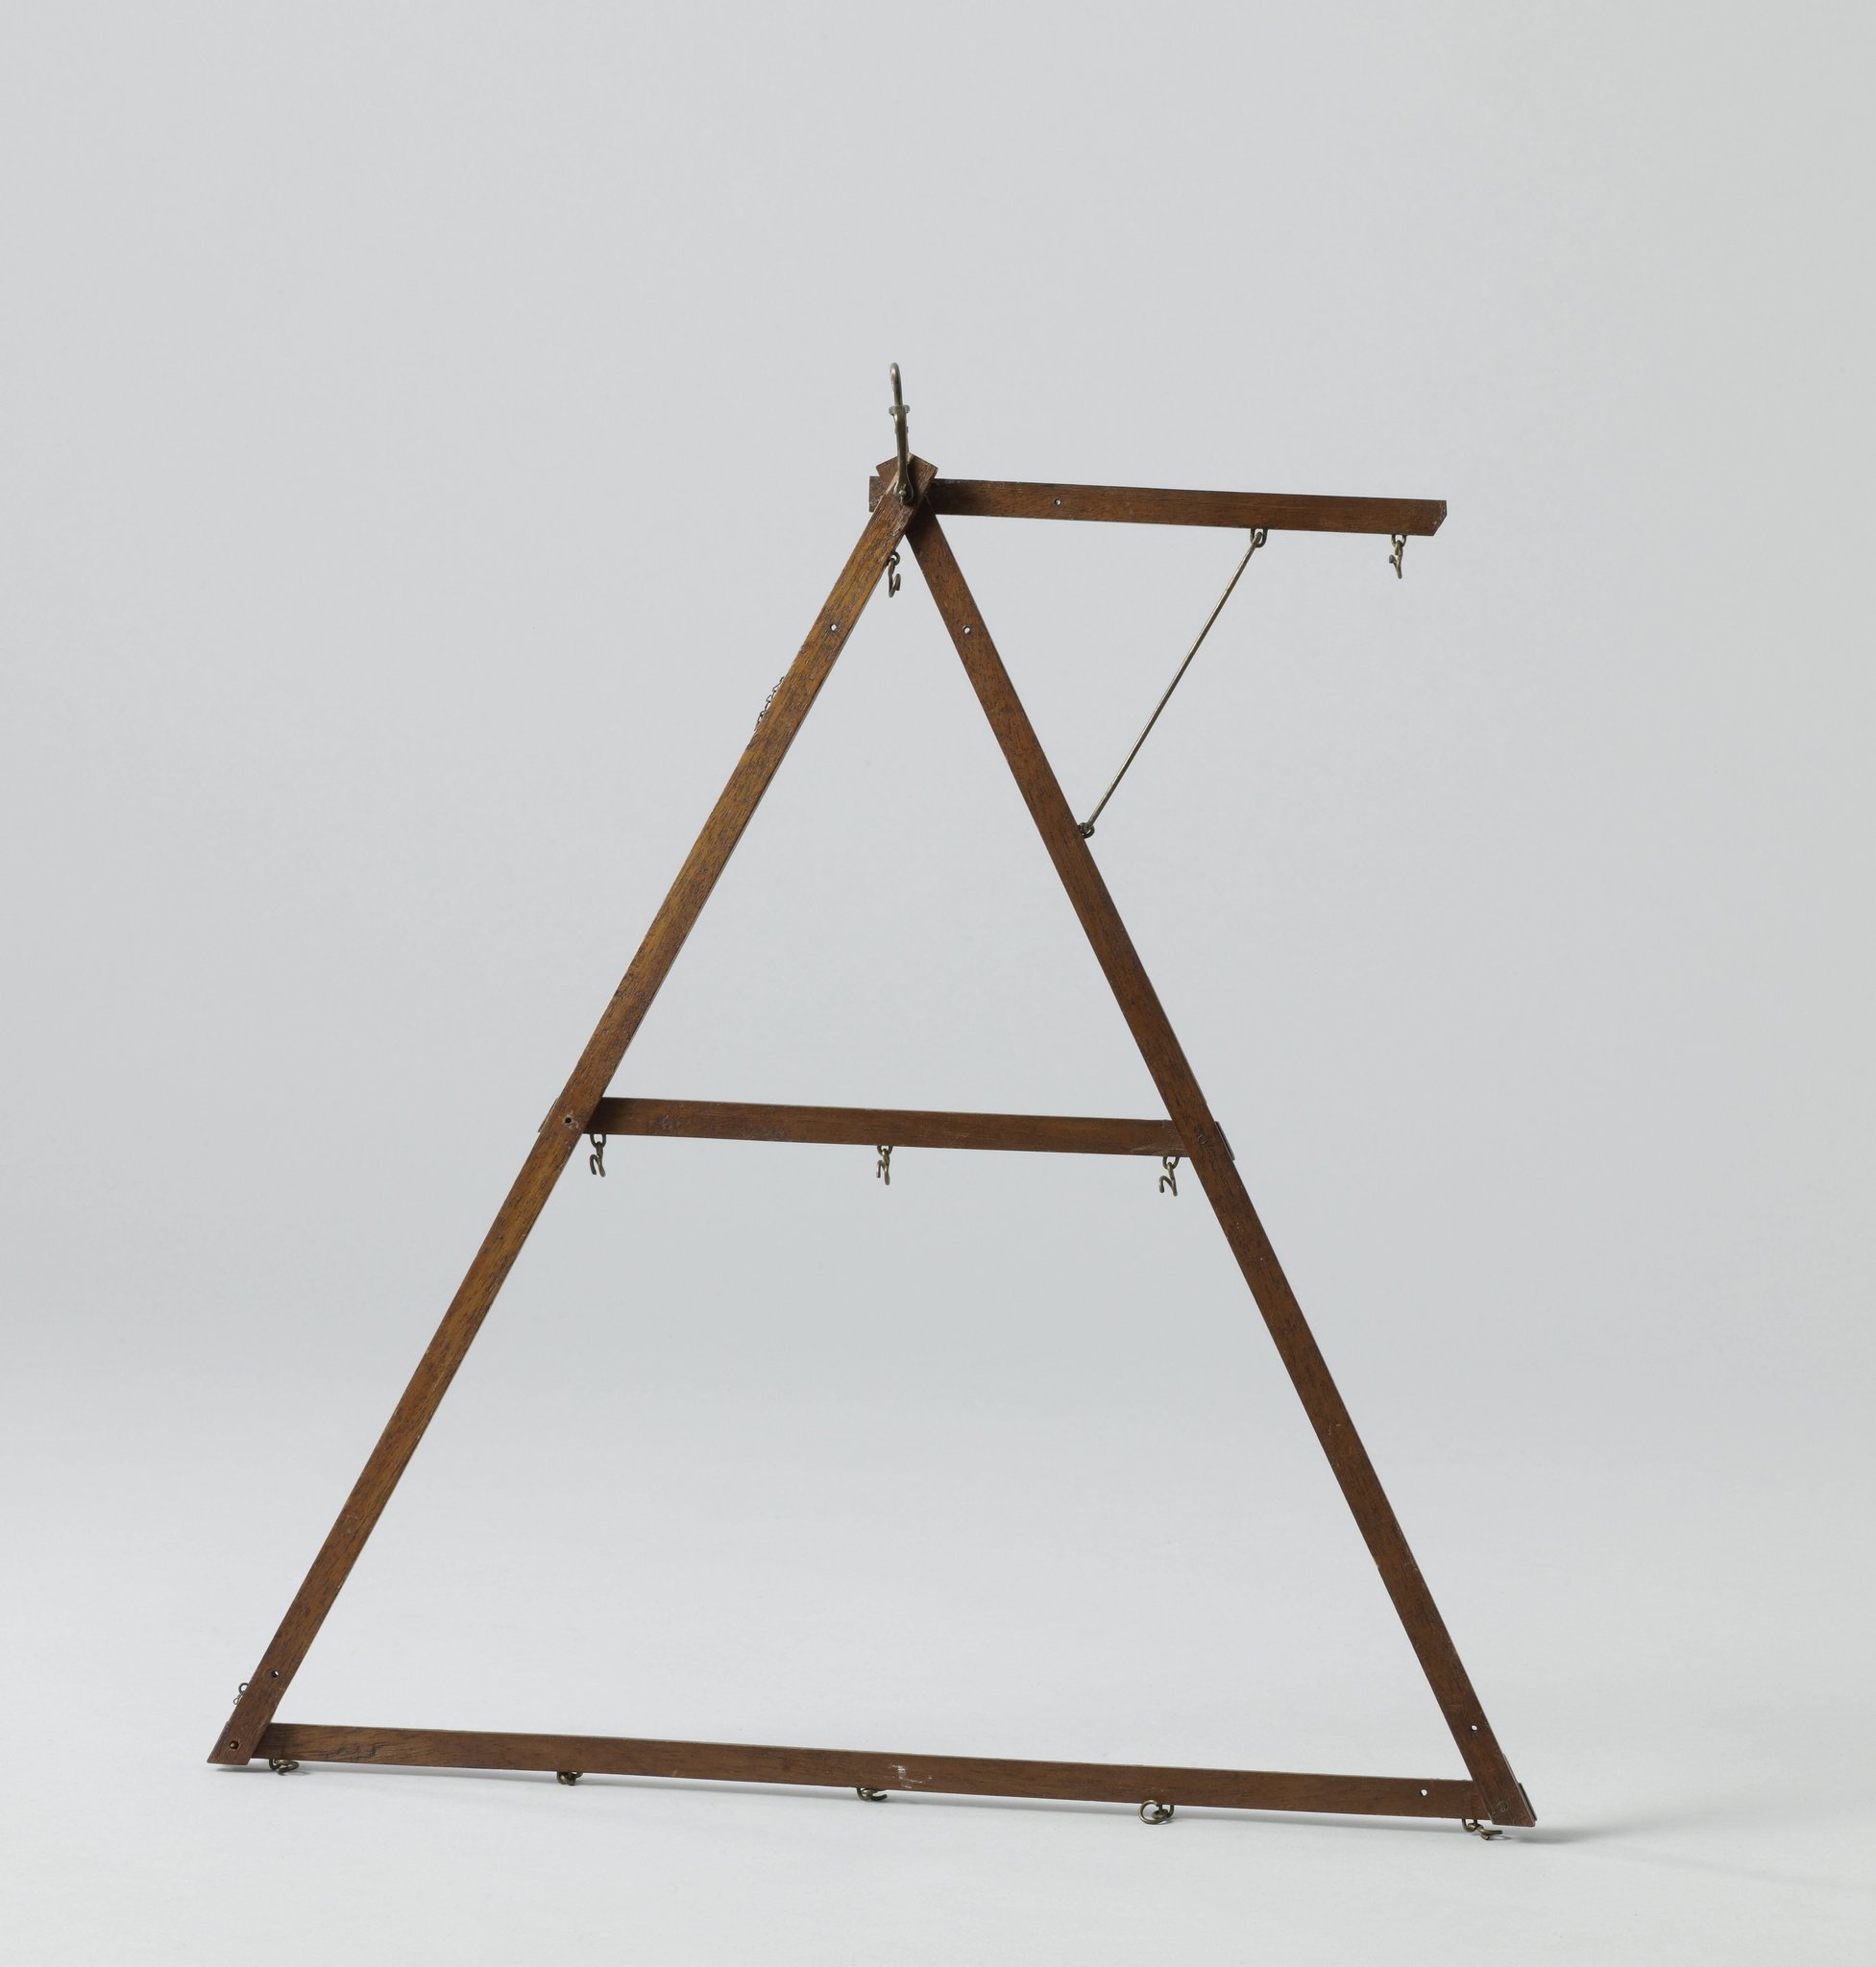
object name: demonstration model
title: Model of a Portable Optical Telegraph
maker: Anonymous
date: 1840-1860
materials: brass, wood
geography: netherlands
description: Model van een draagbare telegraaf, incompleet. Hij bestaat uit een driehoek raamwerk met aan de top een horizontale arm en een ophanghaak. De horizontale latten zijn van haken voorzien, waaraan seinen gehesen kunnen worden. De seinen ontbreken. Het raamwerk kan geheel ingeklapt worden.